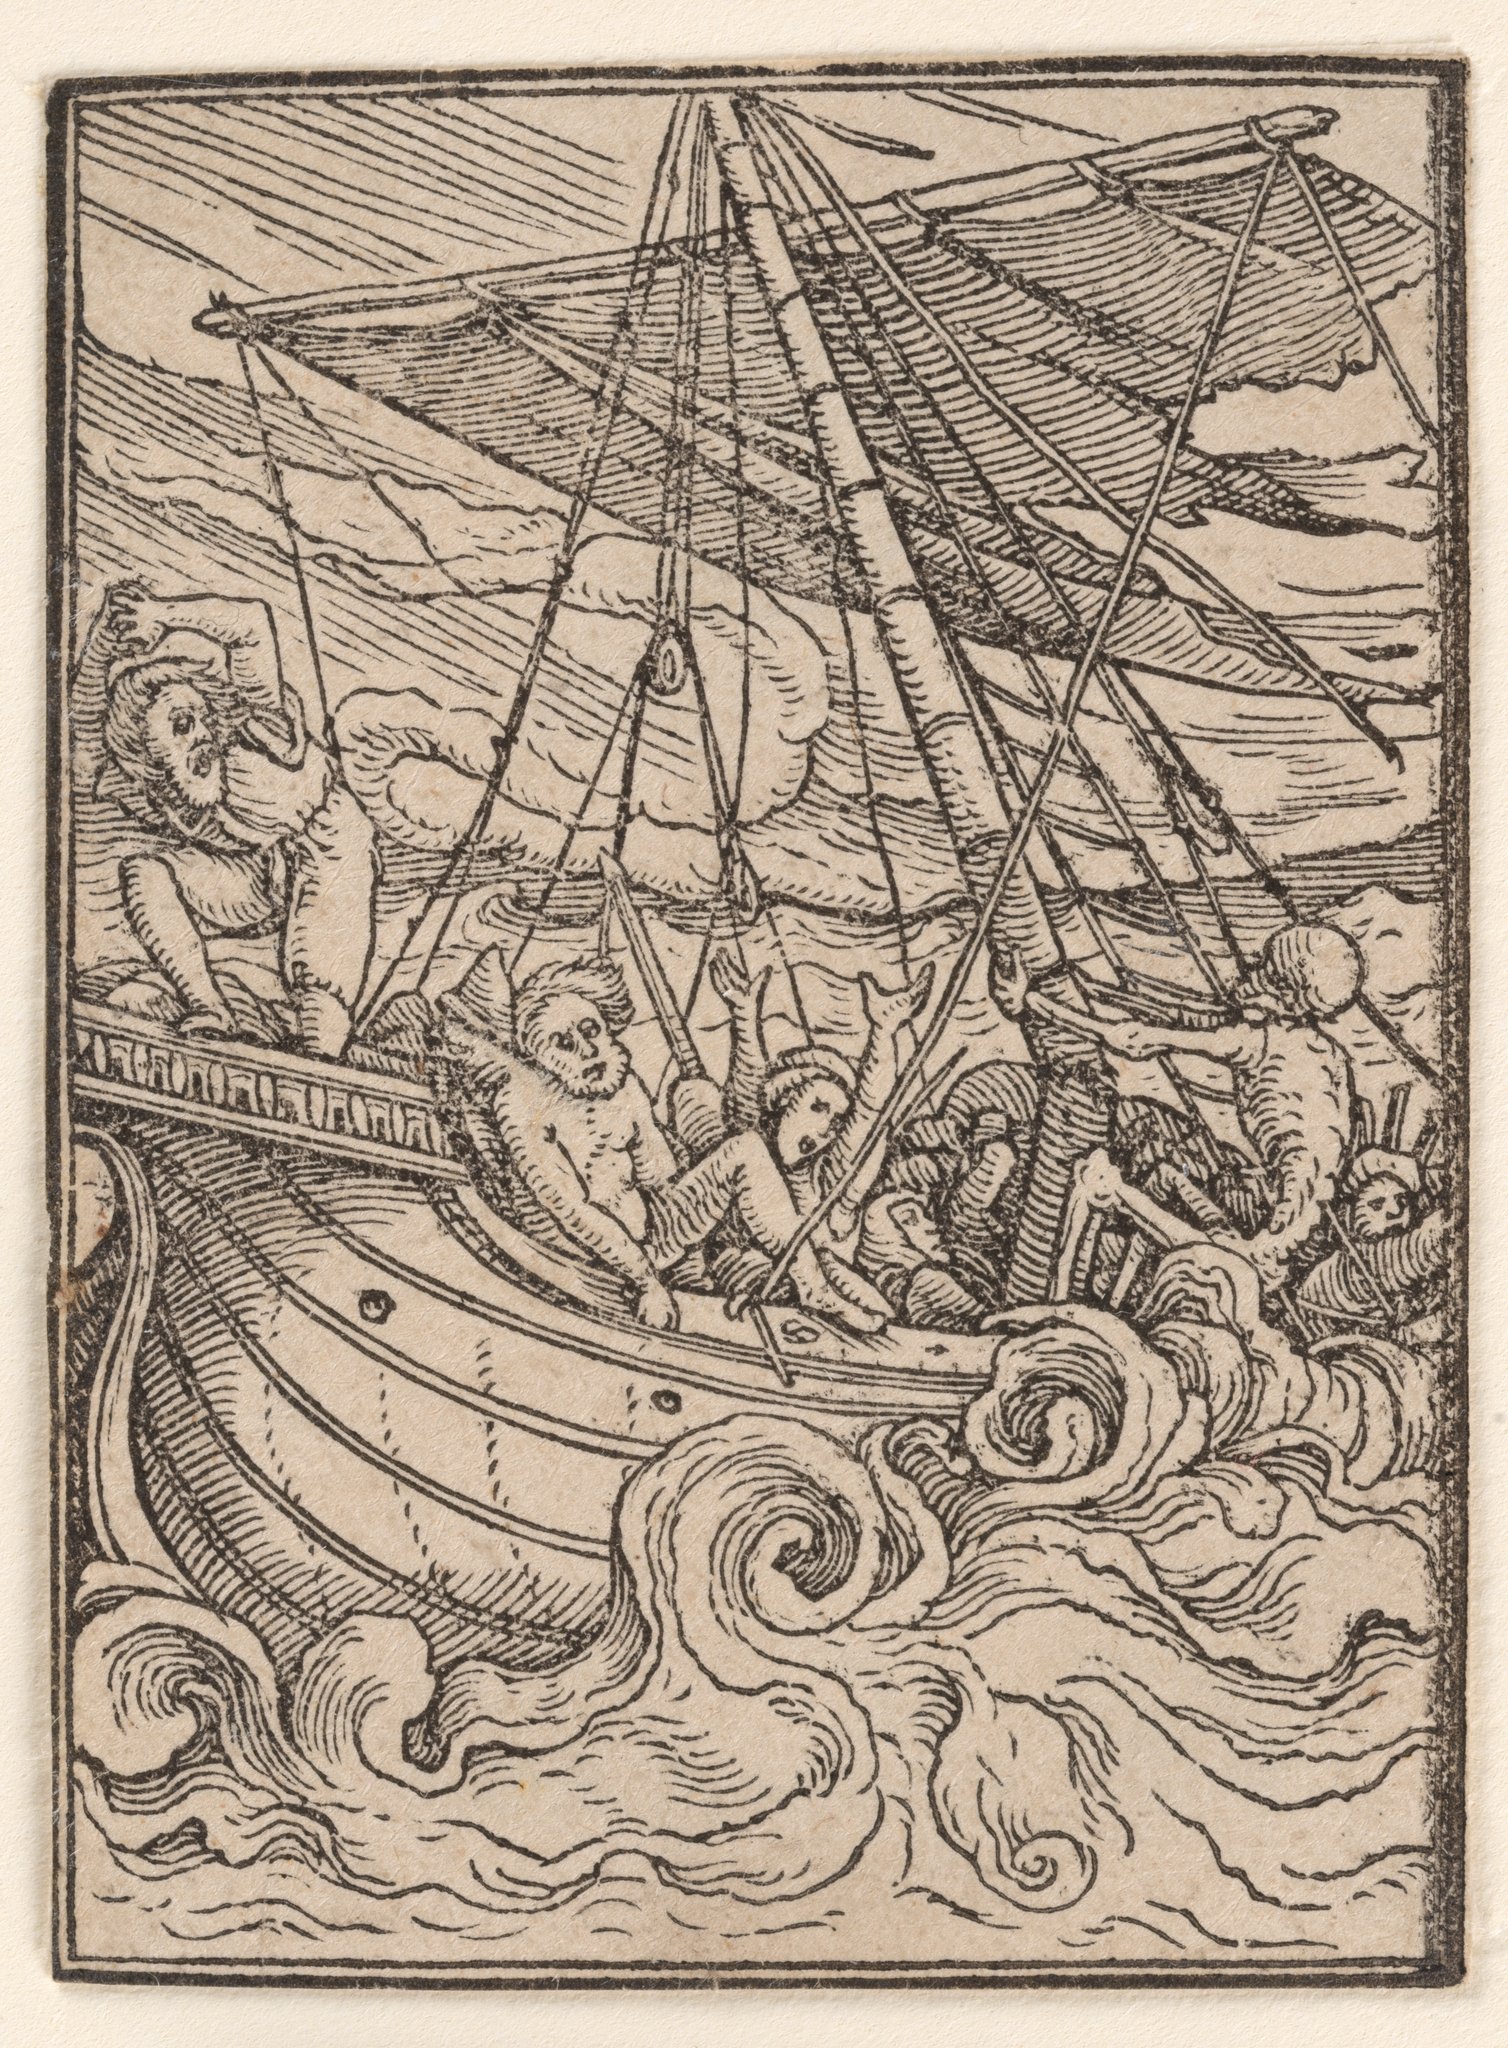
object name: print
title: The Skipper (or Sailor), from "The Dance of Death"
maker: hans holbein the younger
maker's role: artist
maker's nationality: german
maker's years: 1497-1543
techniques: woodcut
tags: skeletons,men,boats